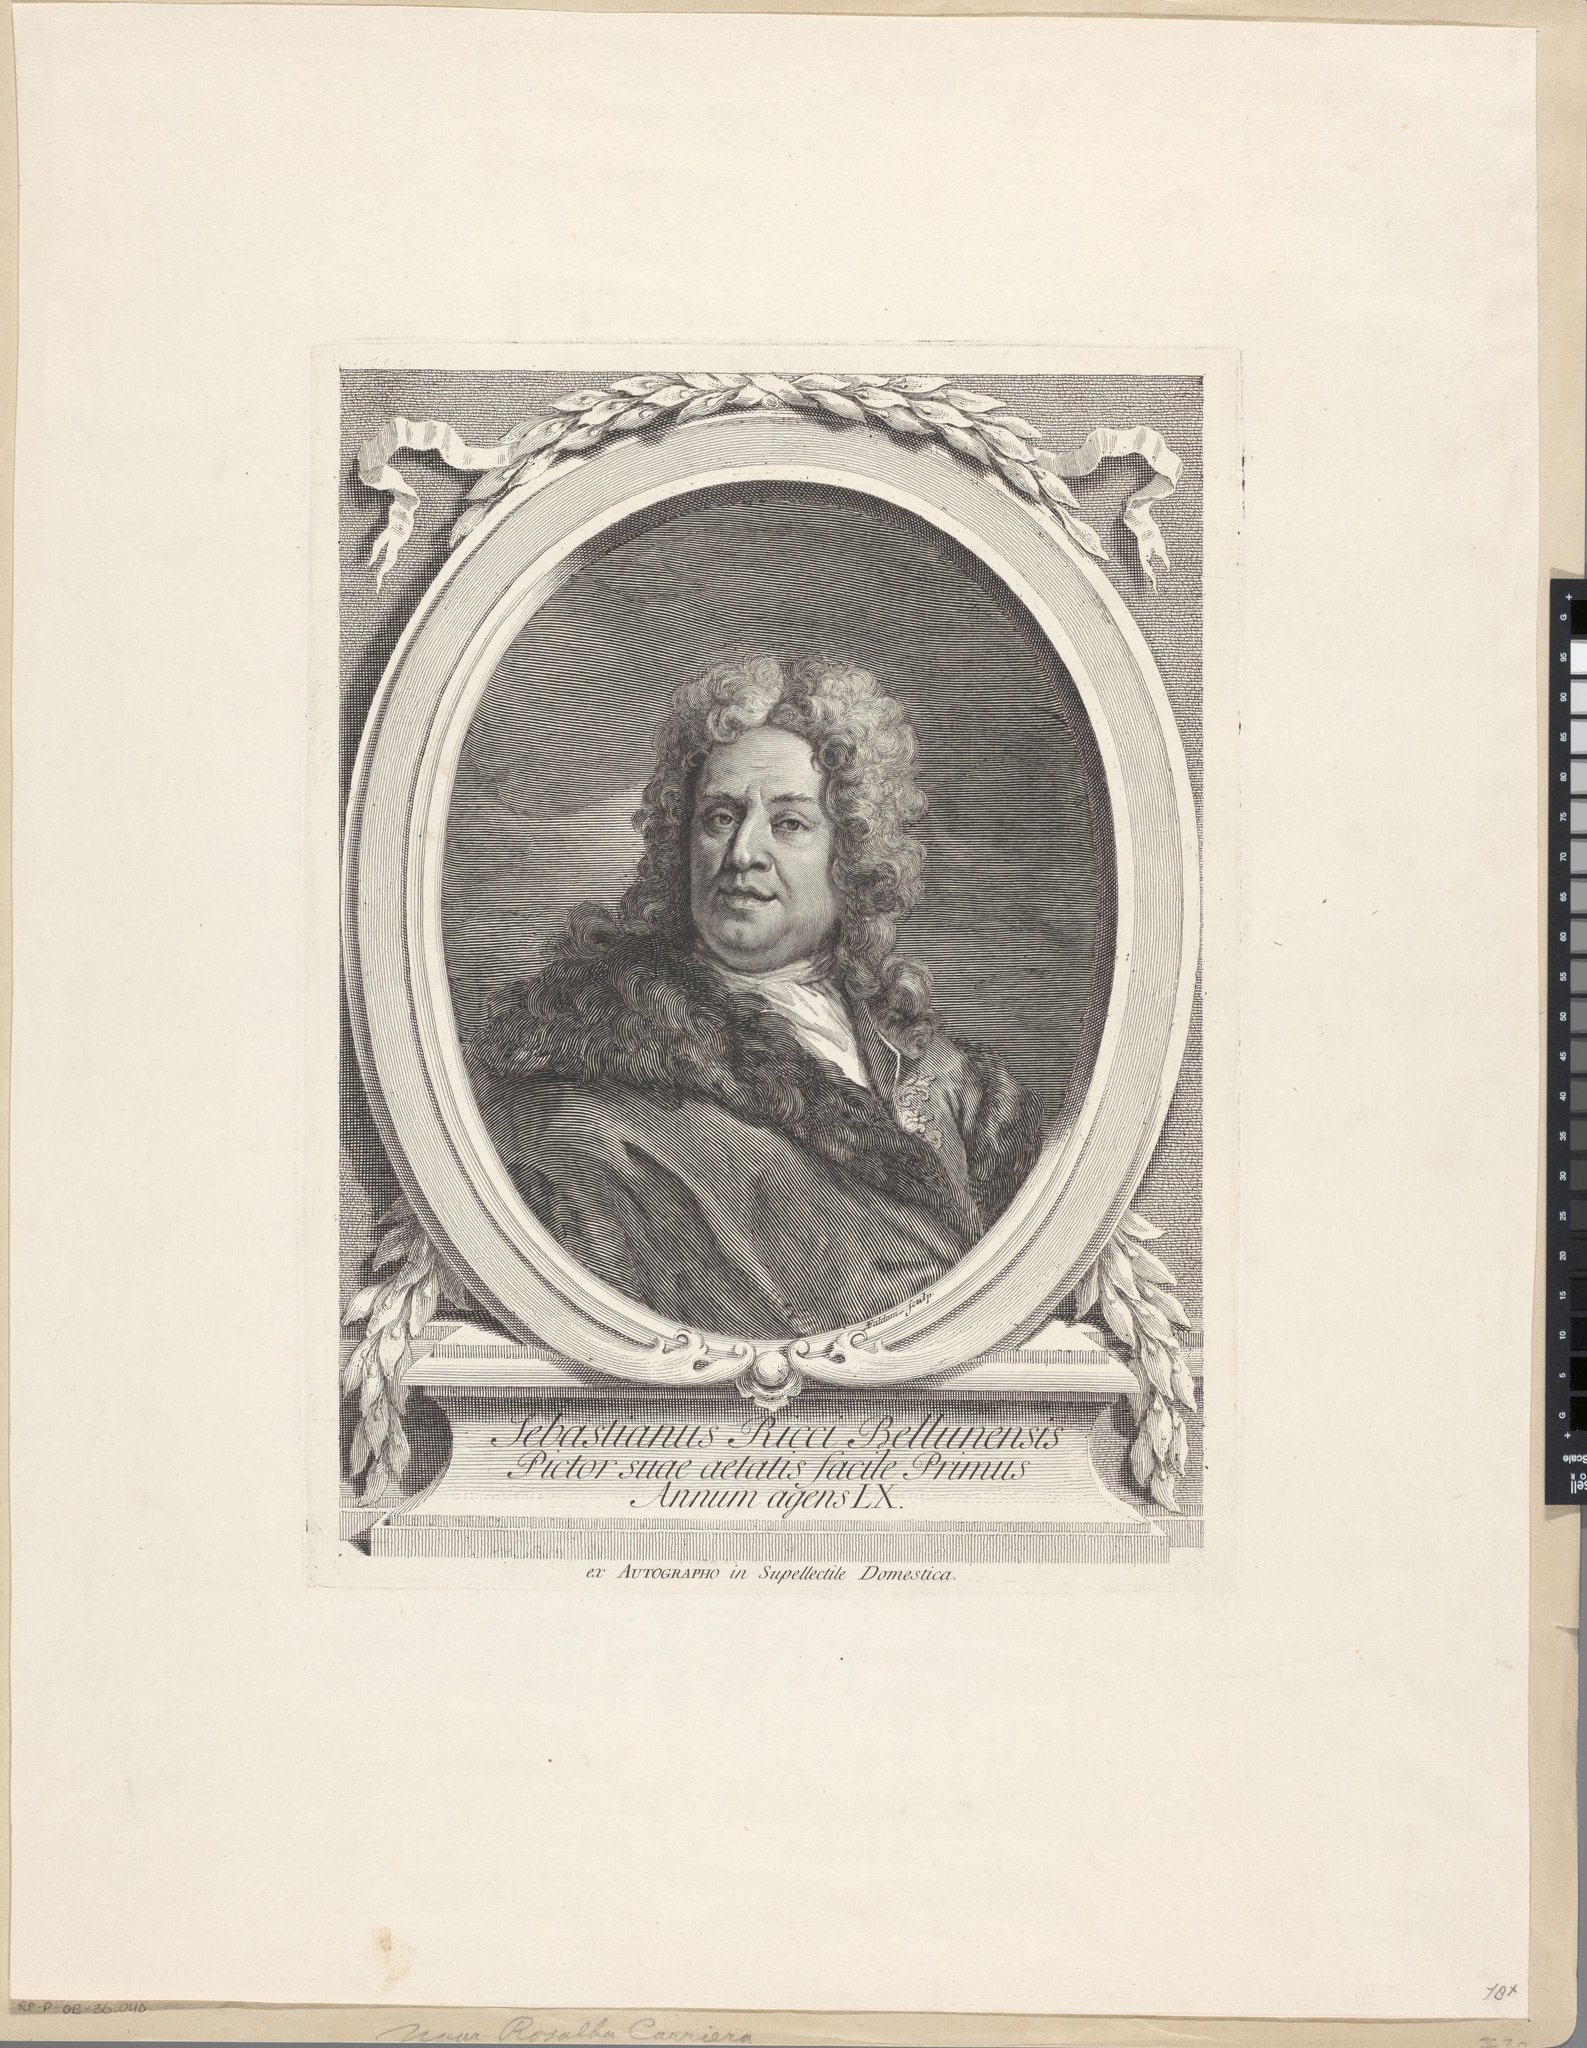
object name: print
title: Portret van schilder Sebastiano Ricci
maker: giovanni antonio faldoni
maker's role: print maker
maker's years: 1690-1780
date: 1700-1760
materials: paper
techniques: engraving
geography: italy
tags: venice, painter, draughtsman, sebastiano ricci, historical persons, portrait, self-portrait of artist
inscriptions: collector's mark: Lugt 2165